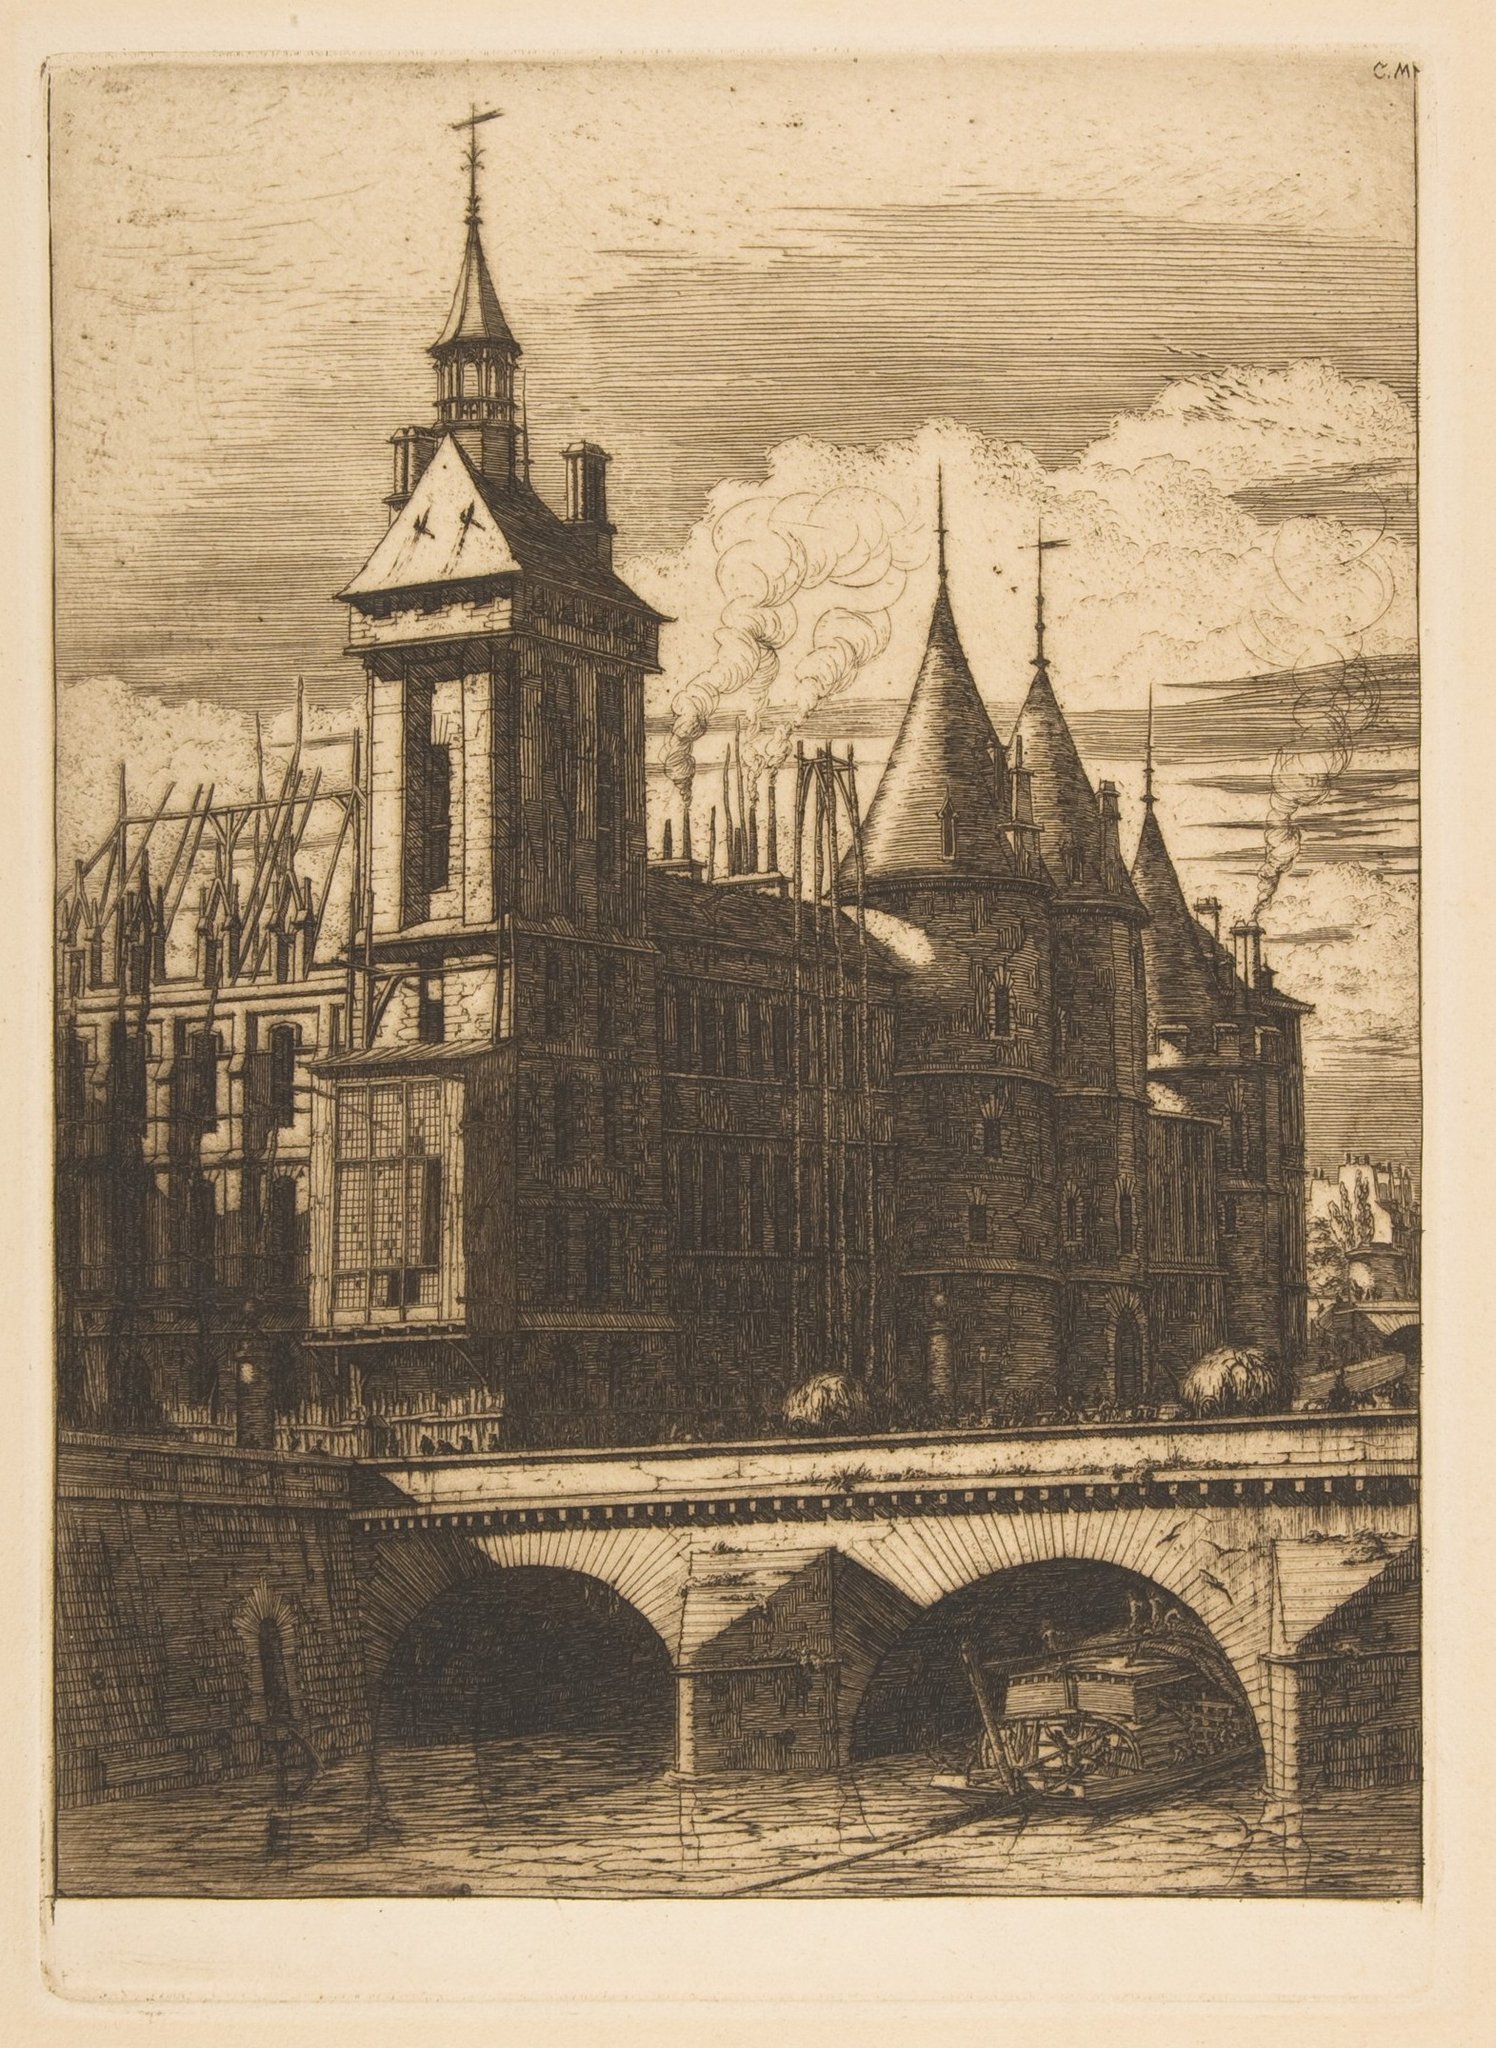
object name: print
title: The Clock Tower, Paris, from "Etchings of Paris"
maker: charles meryon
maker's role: artist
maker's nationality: french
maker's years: 1821-1868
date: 1852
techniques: etching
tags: buildings,towers,cities,bridges,paris